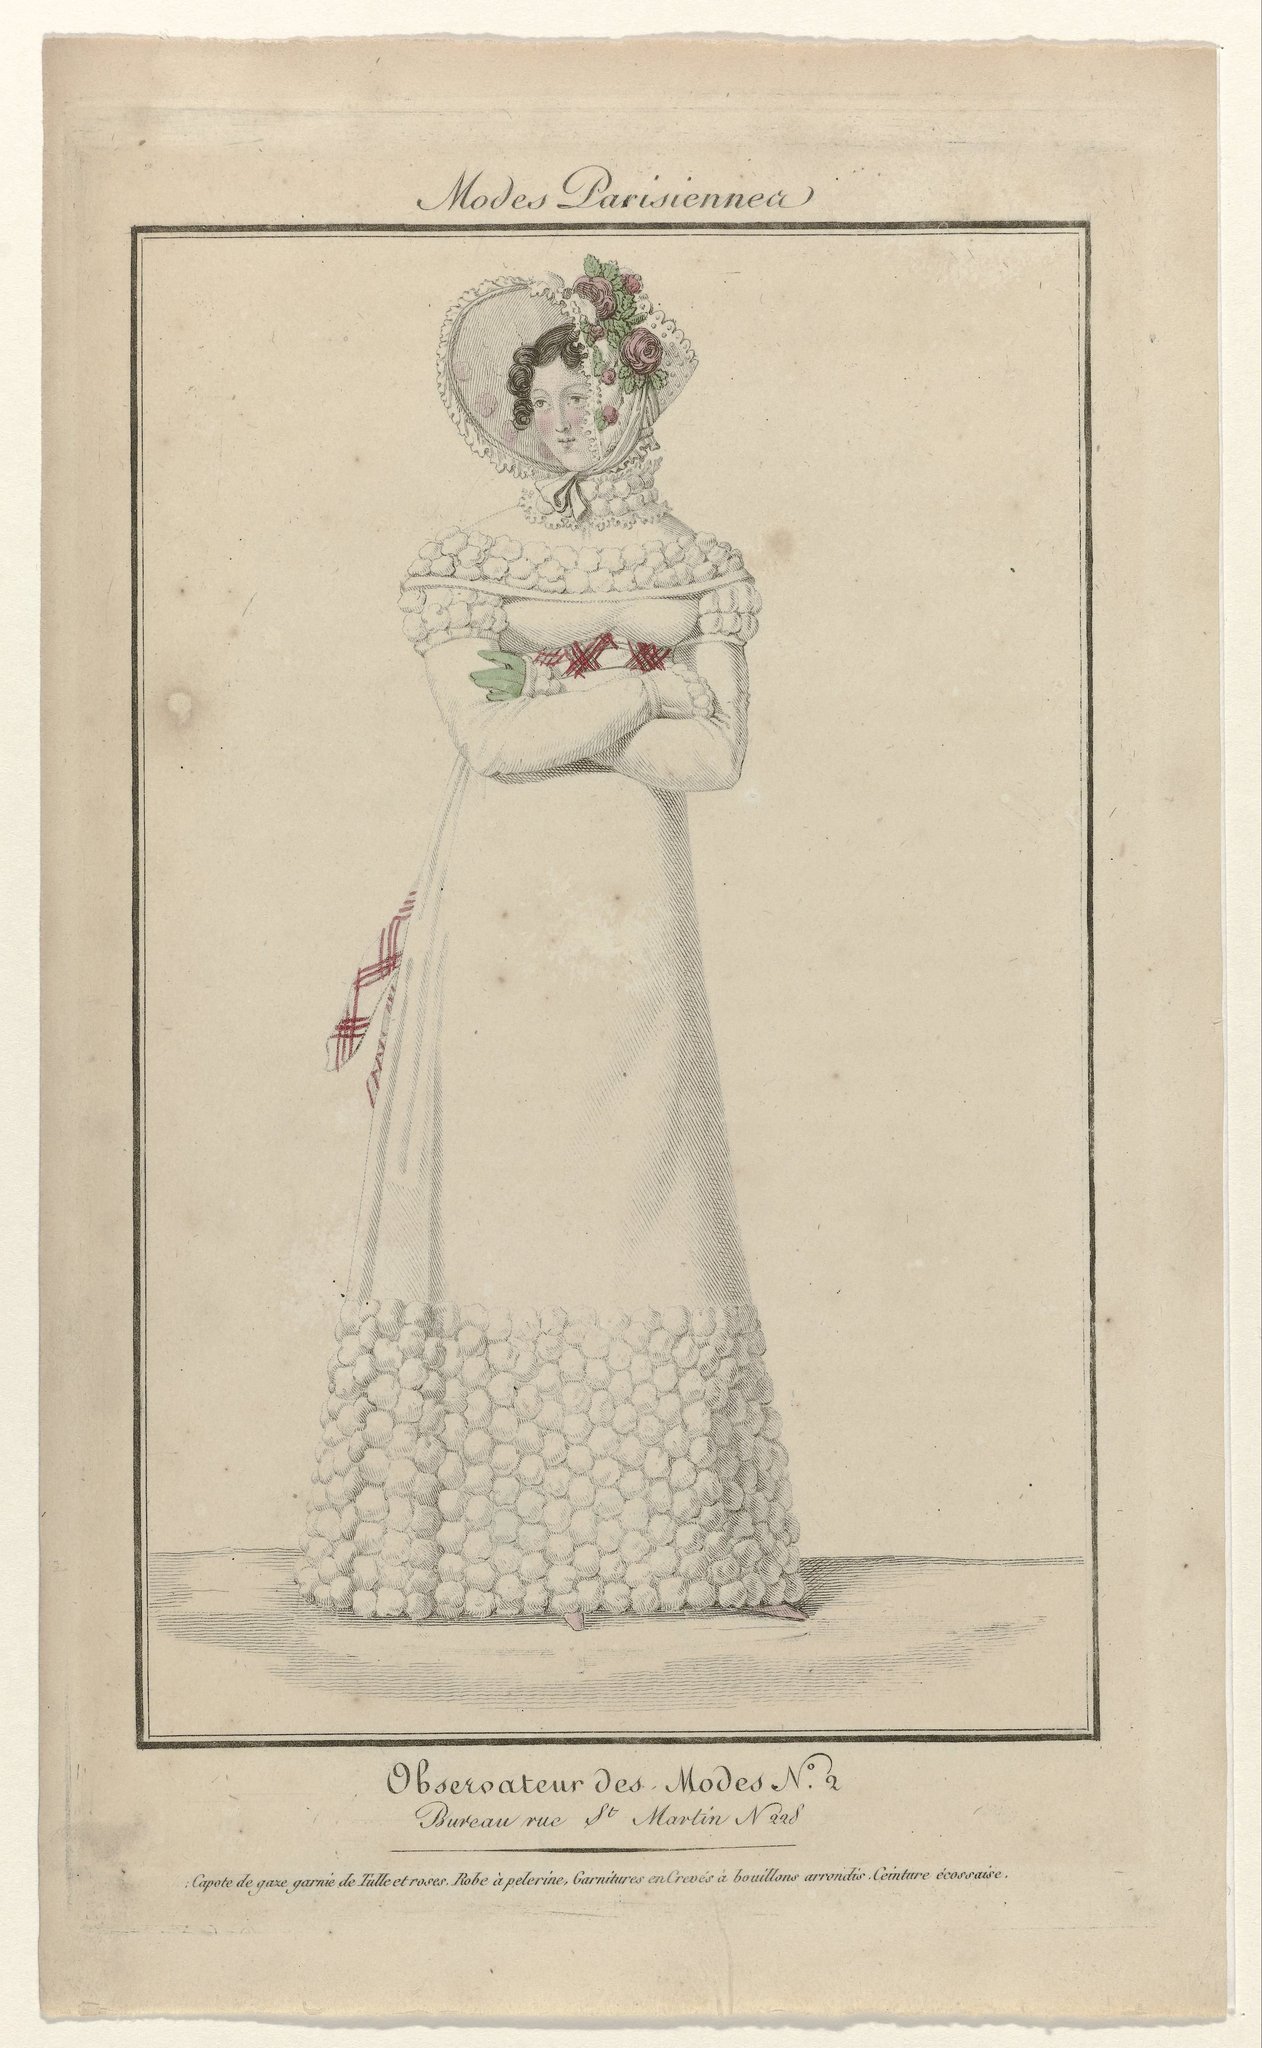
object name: fashion print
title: Observateur des Modes, 1818, No. 2 : Capote de gaz (...)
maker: Anonymous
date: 1818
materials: paper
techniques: engraving, hand coloring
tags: head-gear (capote) (+ women's clothes), ornamental parts of clothing (+ women's clothes), clothing for the upper part of the body (mantelet) (+ women's clothes), fashion plates, gloves, mittens, etc. (+ women's clothes), dress, gown (+ women's clothes), flowers: rose, belt, girdle, waistband (+ women's clothes)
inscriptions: title: ‘Modes Parisiennes’, title: ‘Observateur des Modes, No. 2’, address: ‘Bureau rue S"t Martin, No. 228.’, caption: ‘Capote de gaze garnie de Tulle et roses. Robe à pelerine, Garnitures en crevés à bouillons arrondis. Ceinture écossaise.’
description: 'Capote' van tule, versierd met tule en rozen. Japon met pelerine, 'garneringen en crevés à bouillons arrondis'. Schots geruite ceintuur. Prent uit het modetijdschrift Observateur des Modes (août 1818 - 30 novembre 1823).